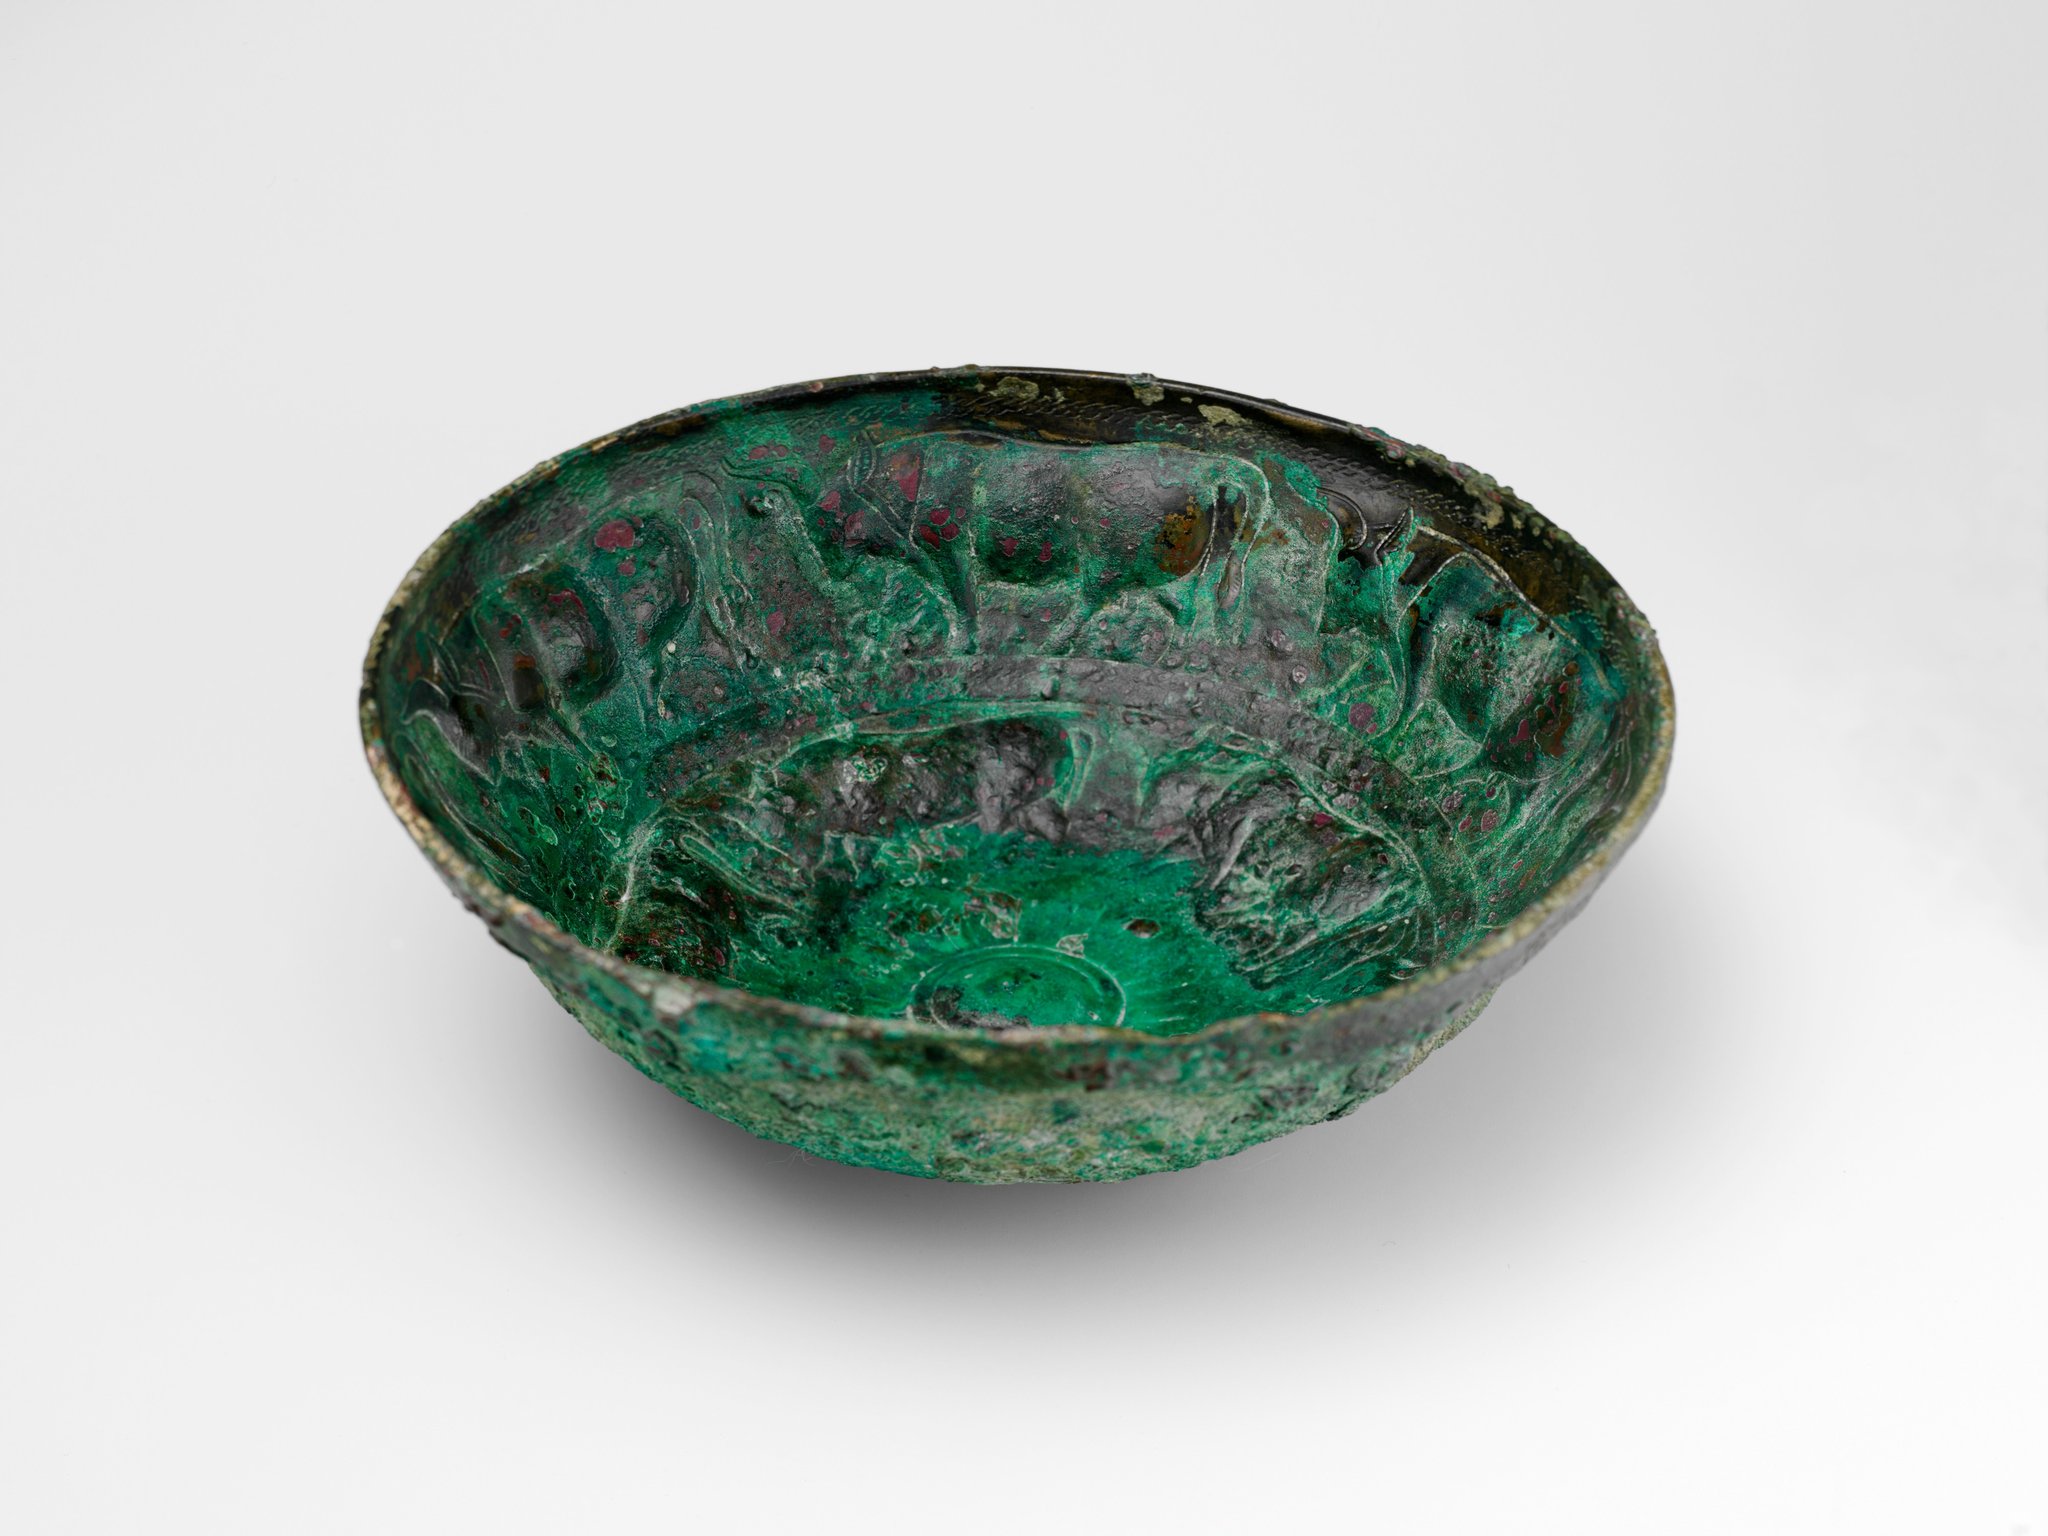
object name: bowl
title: Bowl with bands of striding bulls and two inscriptions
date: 800-601 BCE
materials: bronze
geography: syria or levant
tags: bulls